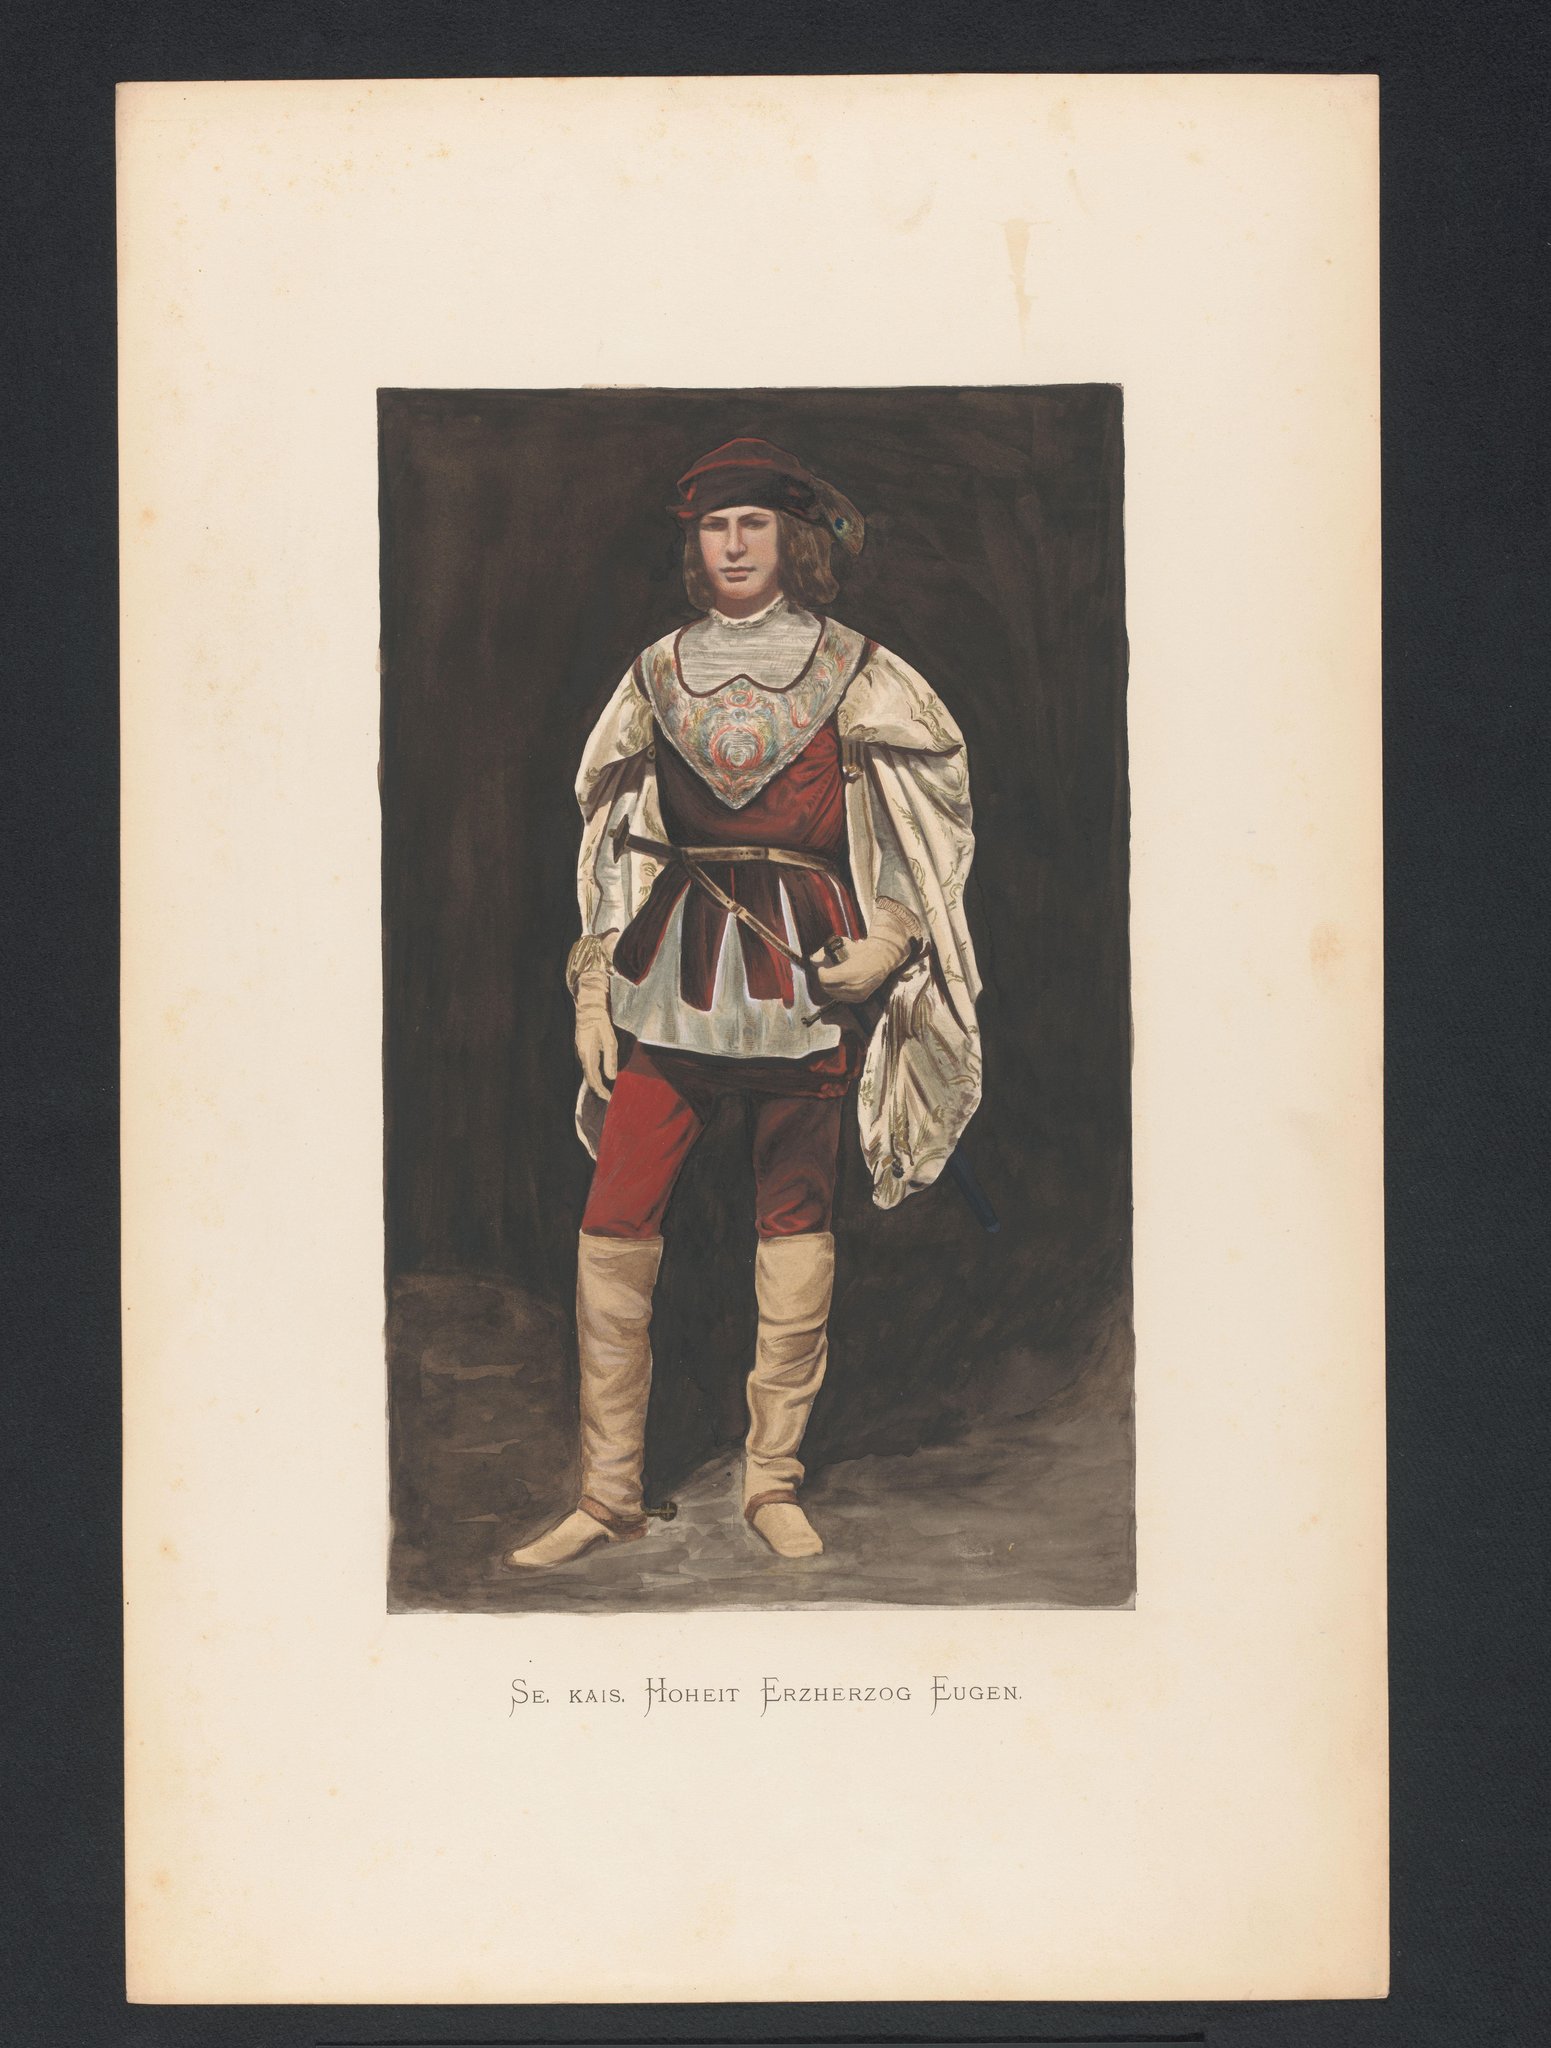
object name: photomechanical print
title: Se. kais. Hoheit Erzherzog Eugen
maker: Anonymous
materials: paper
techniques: photograph, hand coloring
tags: aristocracy; 'aristocratia' (ripa), historical persons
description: Deze prent maakt deel uit van een omslag met 86 prenten op 78 bladen en 11 tekstbladen.